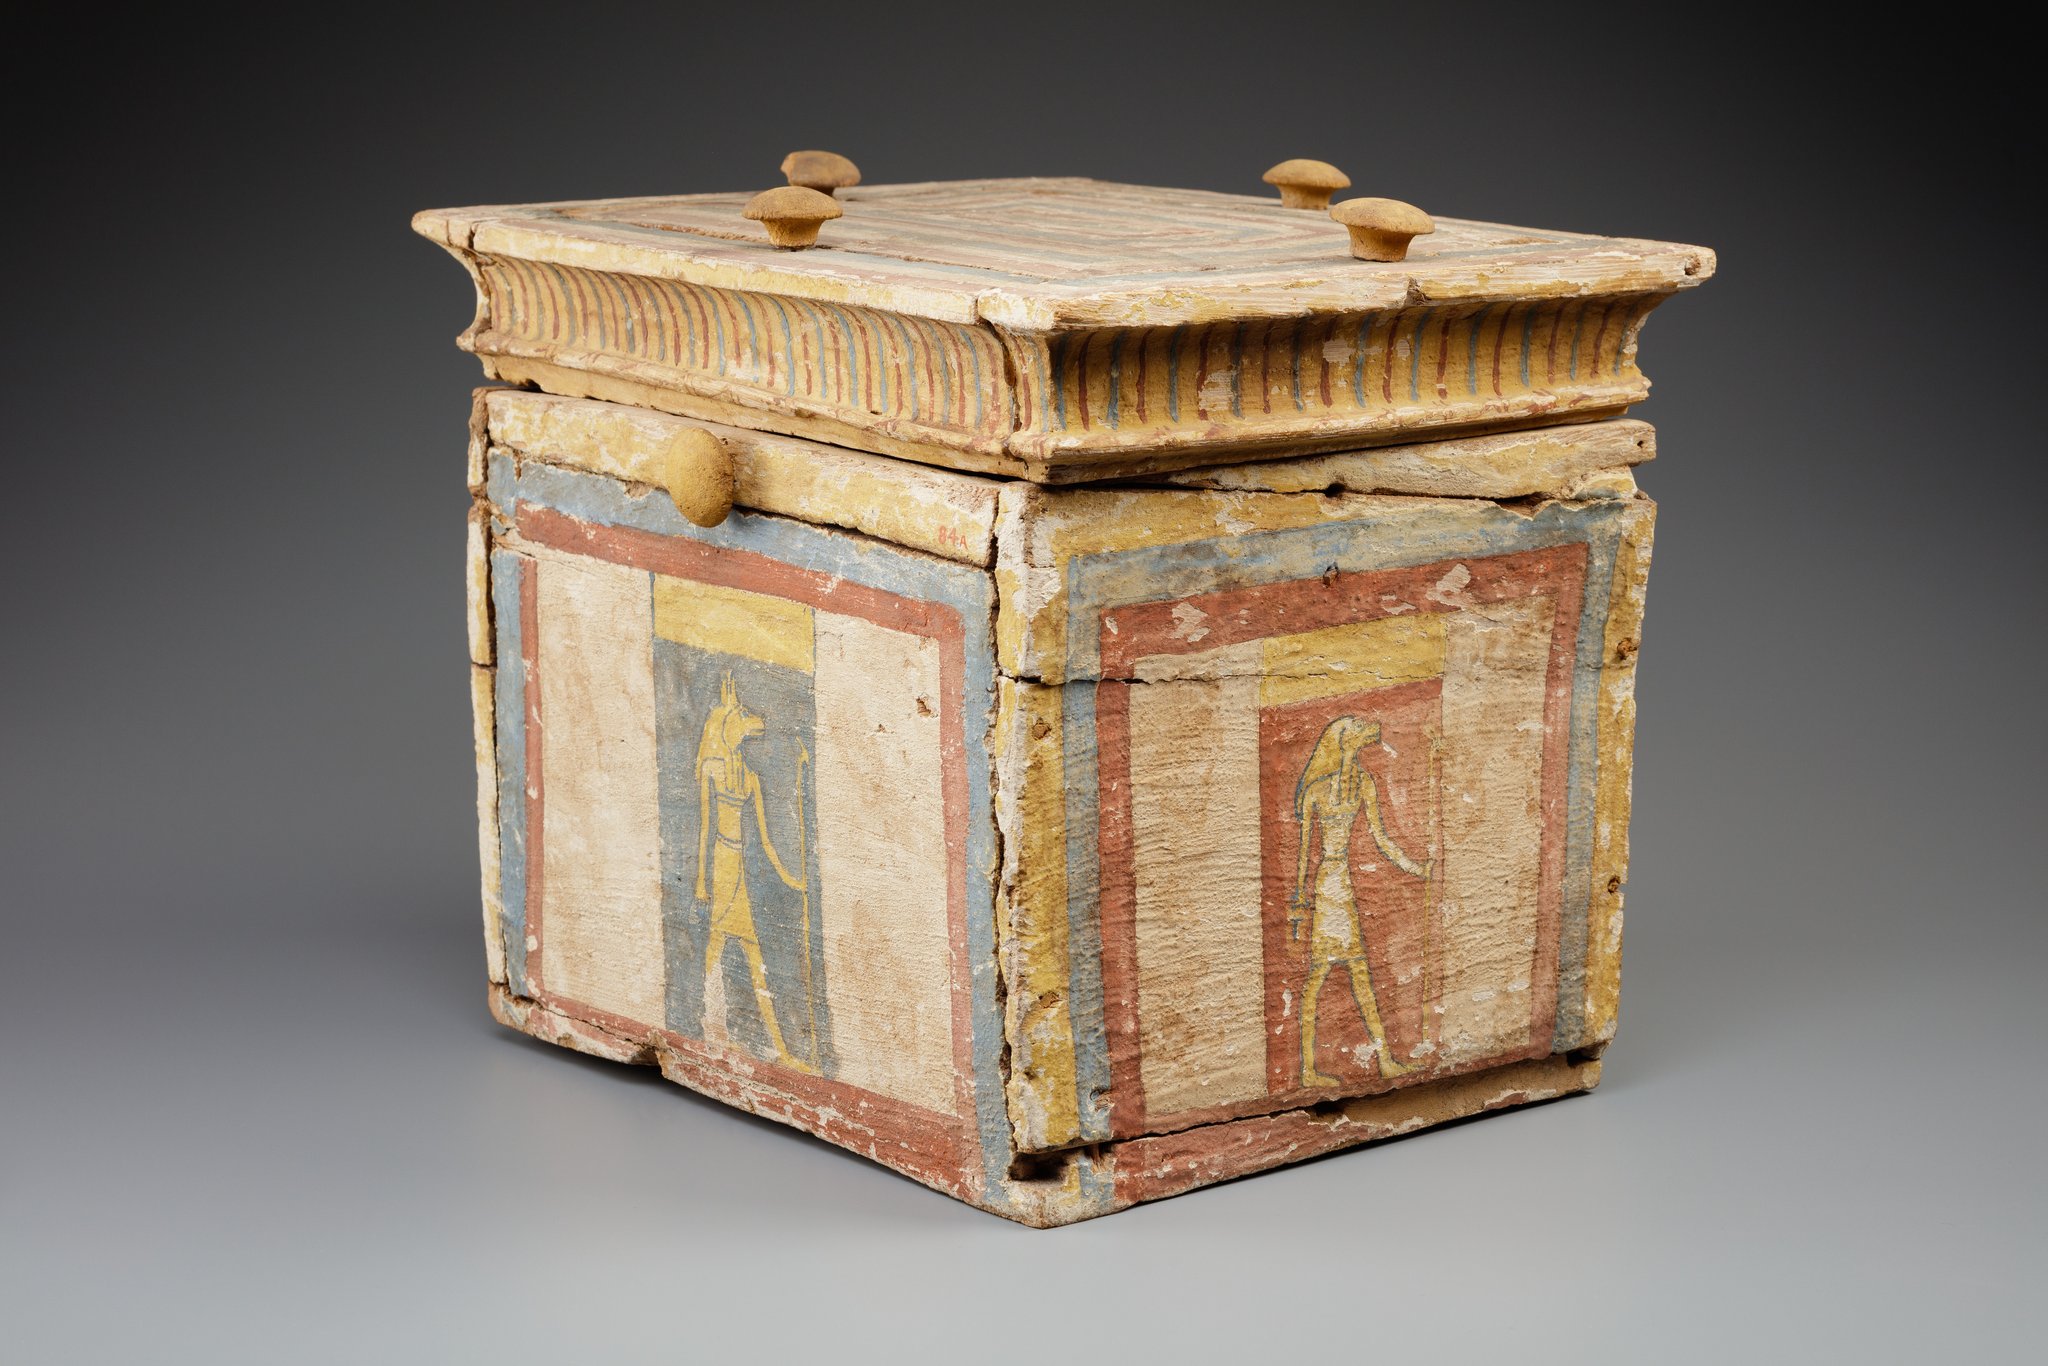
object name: canopic chest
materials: gesso, paint, wood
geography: egypt